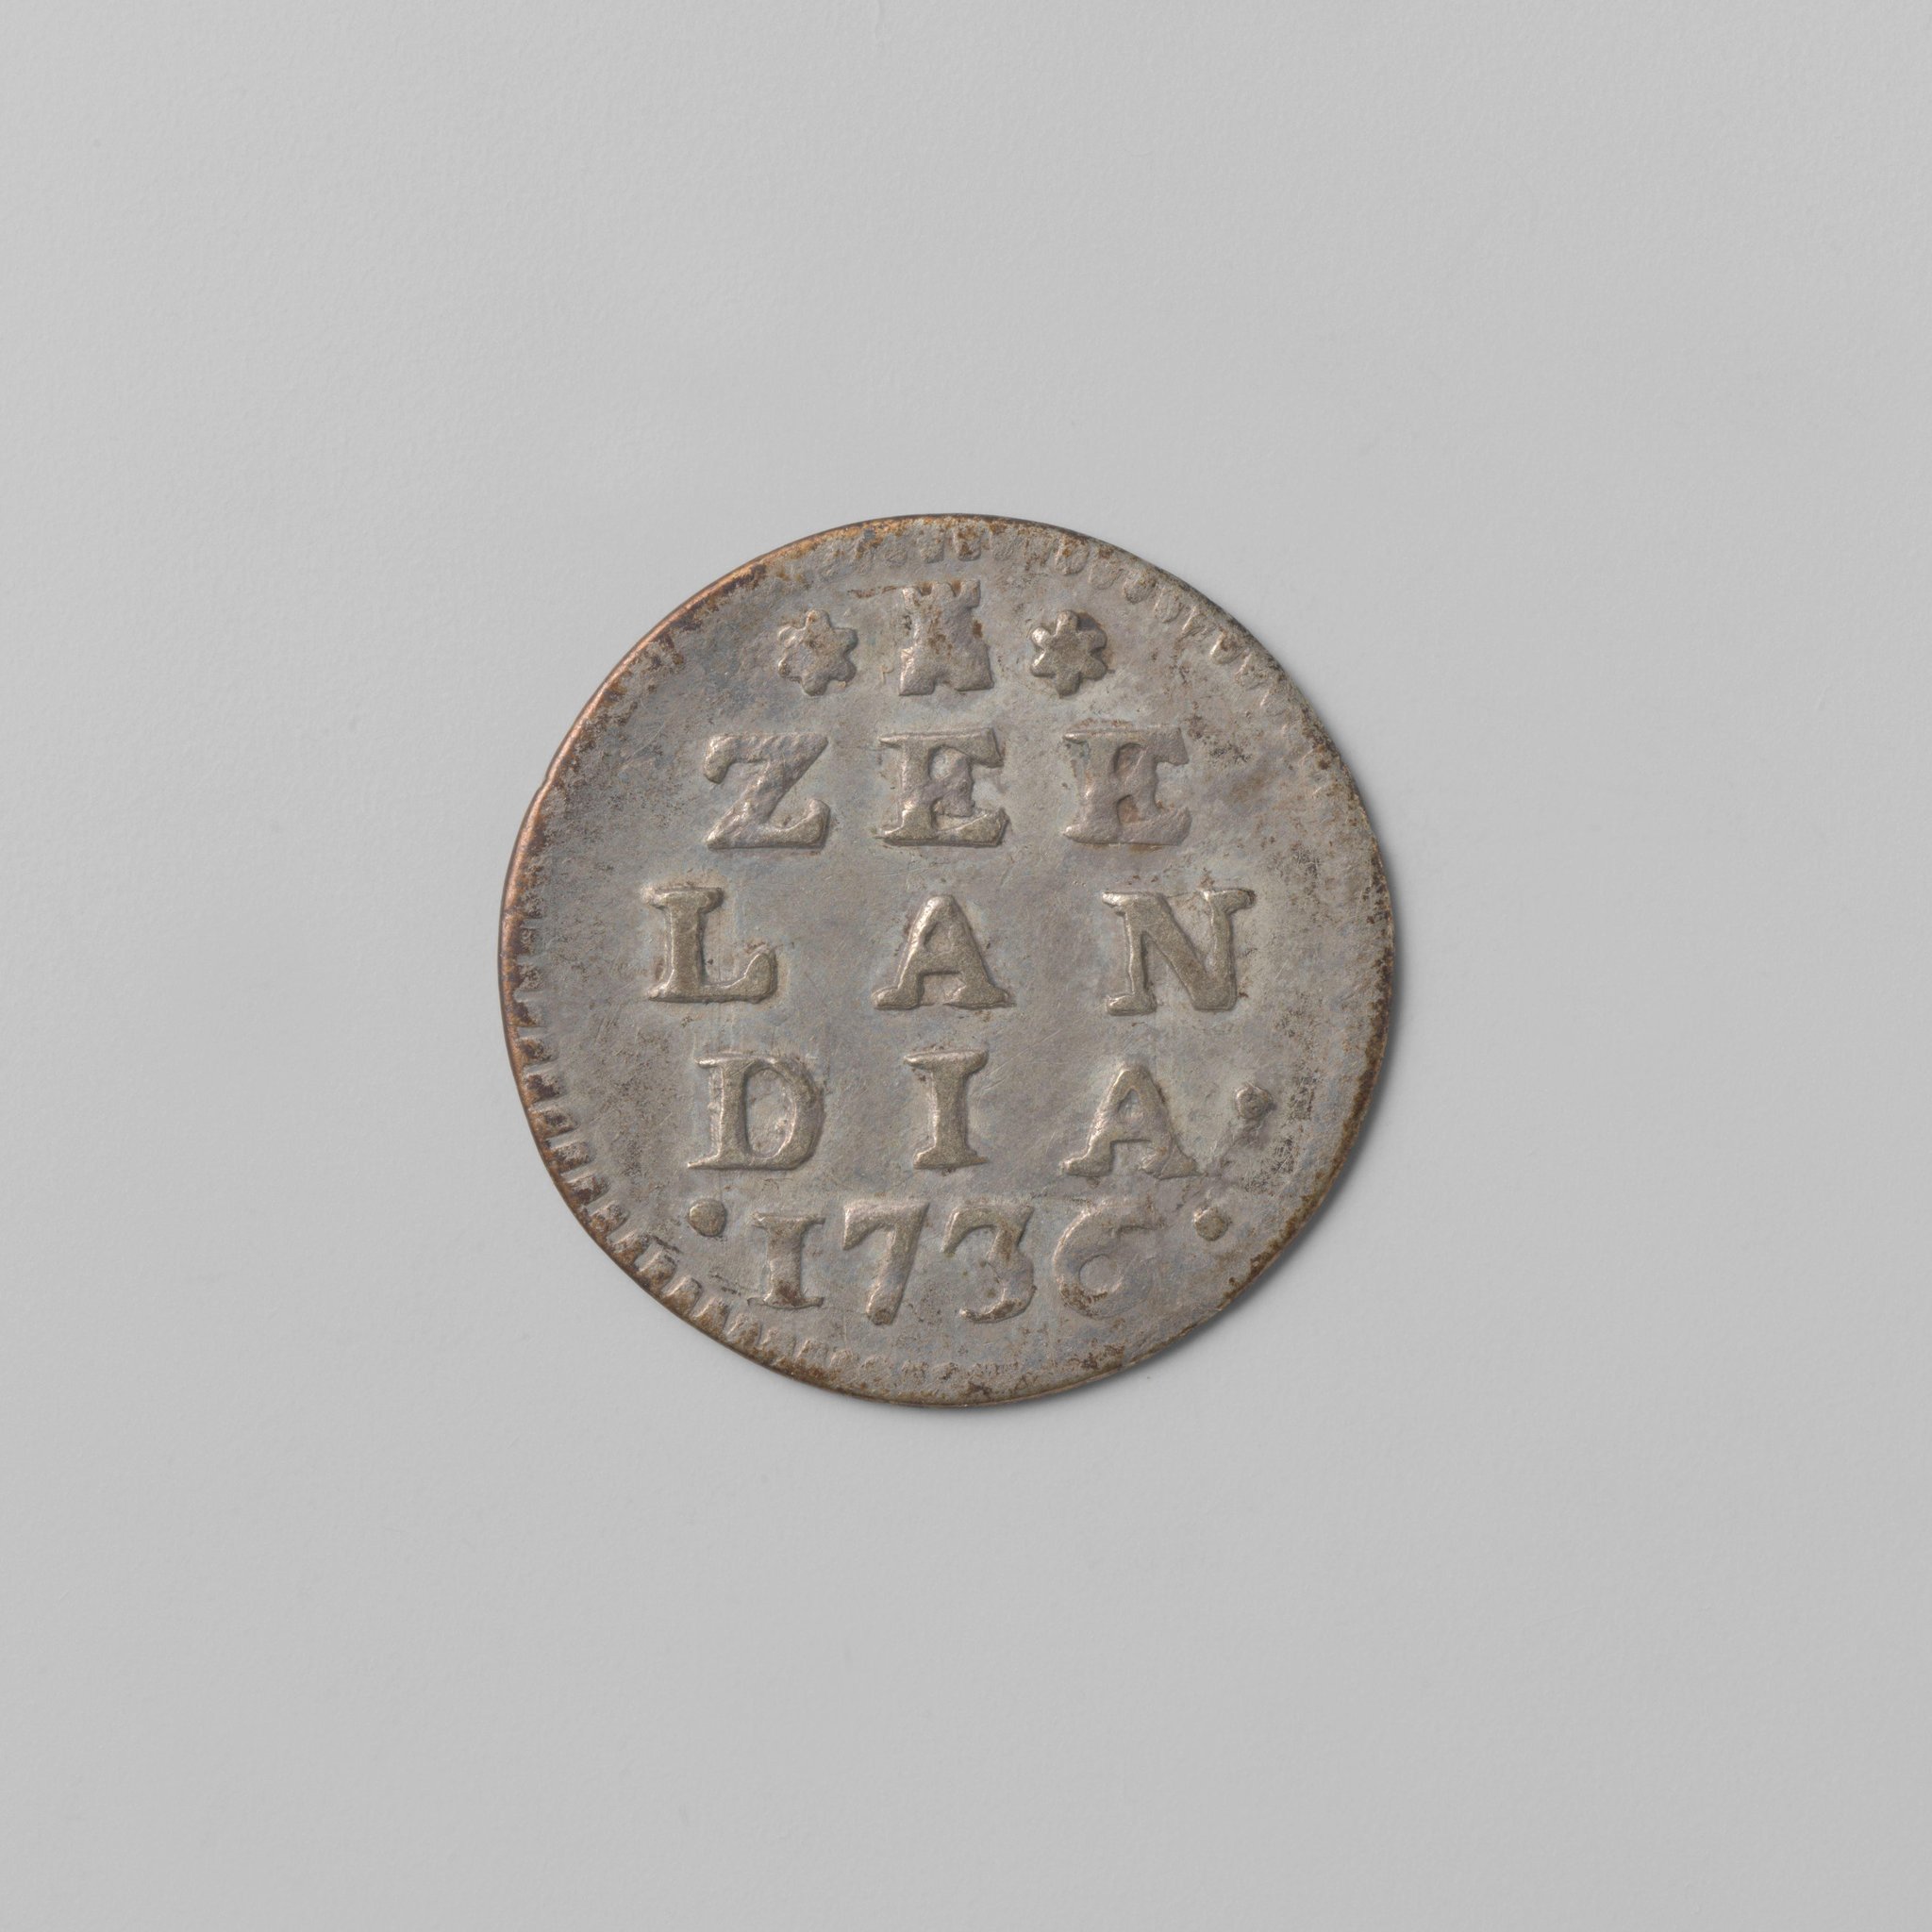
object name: coin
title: Zeeuwse dubbele stuiver, 1736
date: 1736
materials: silver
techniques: striking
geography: middelburg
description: Zilveren munt. Voorzijde: tussen waarde-aanduiding 2 S gekroond wapenschild van Zeeland. Keerzijde: opschrift in drie regels, waarboven muntteken burcht tussen twee rozetten en waaronder jaartal.